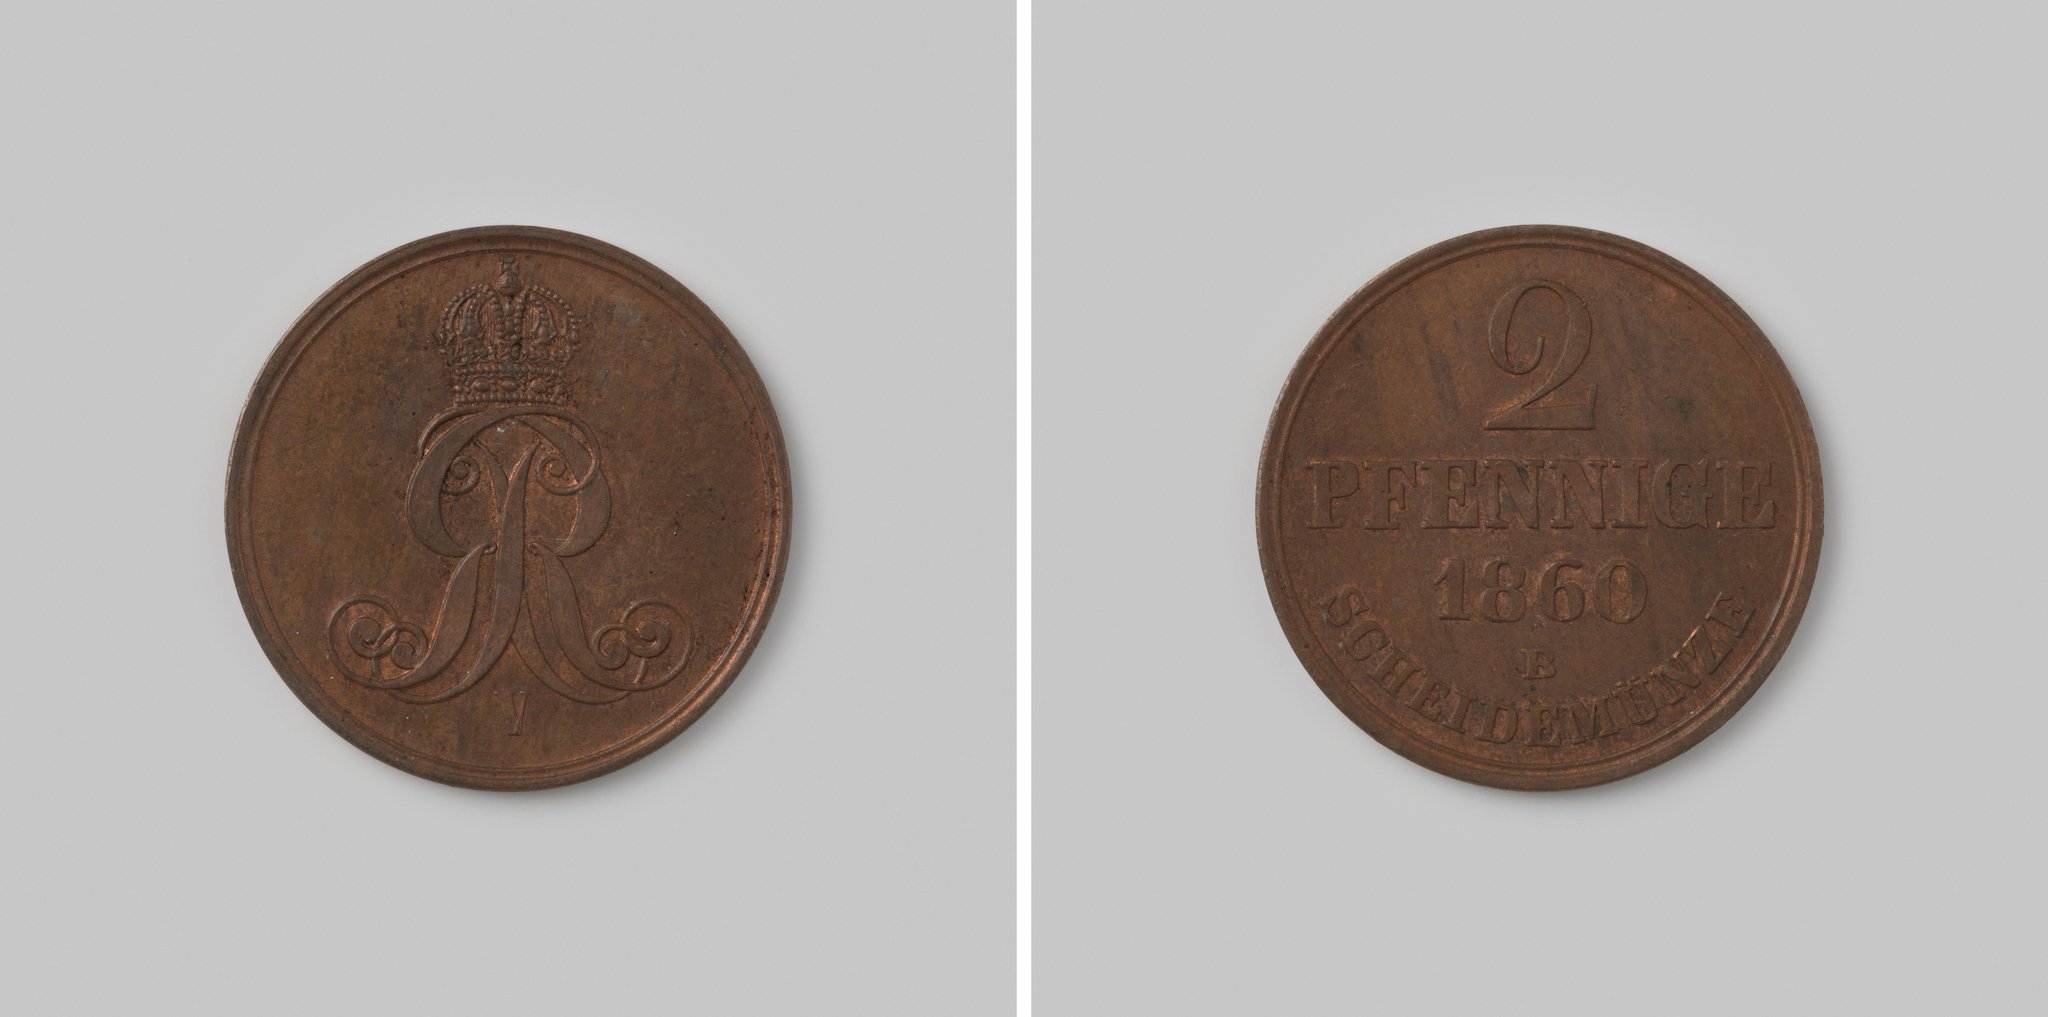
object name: coin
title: 2 Pfennige uit het koninkrijk Hannover van Georg V, 1860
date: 1860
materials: copper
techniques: striking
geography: hannover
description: Koperen munt. Voorzijde: gekroond monogram, waaronder Romneinse cijfer V. Keerzijde: waarde-aanduiding in twee regels, waaronder jaartal. Daaronder letter B. Gladde rand.